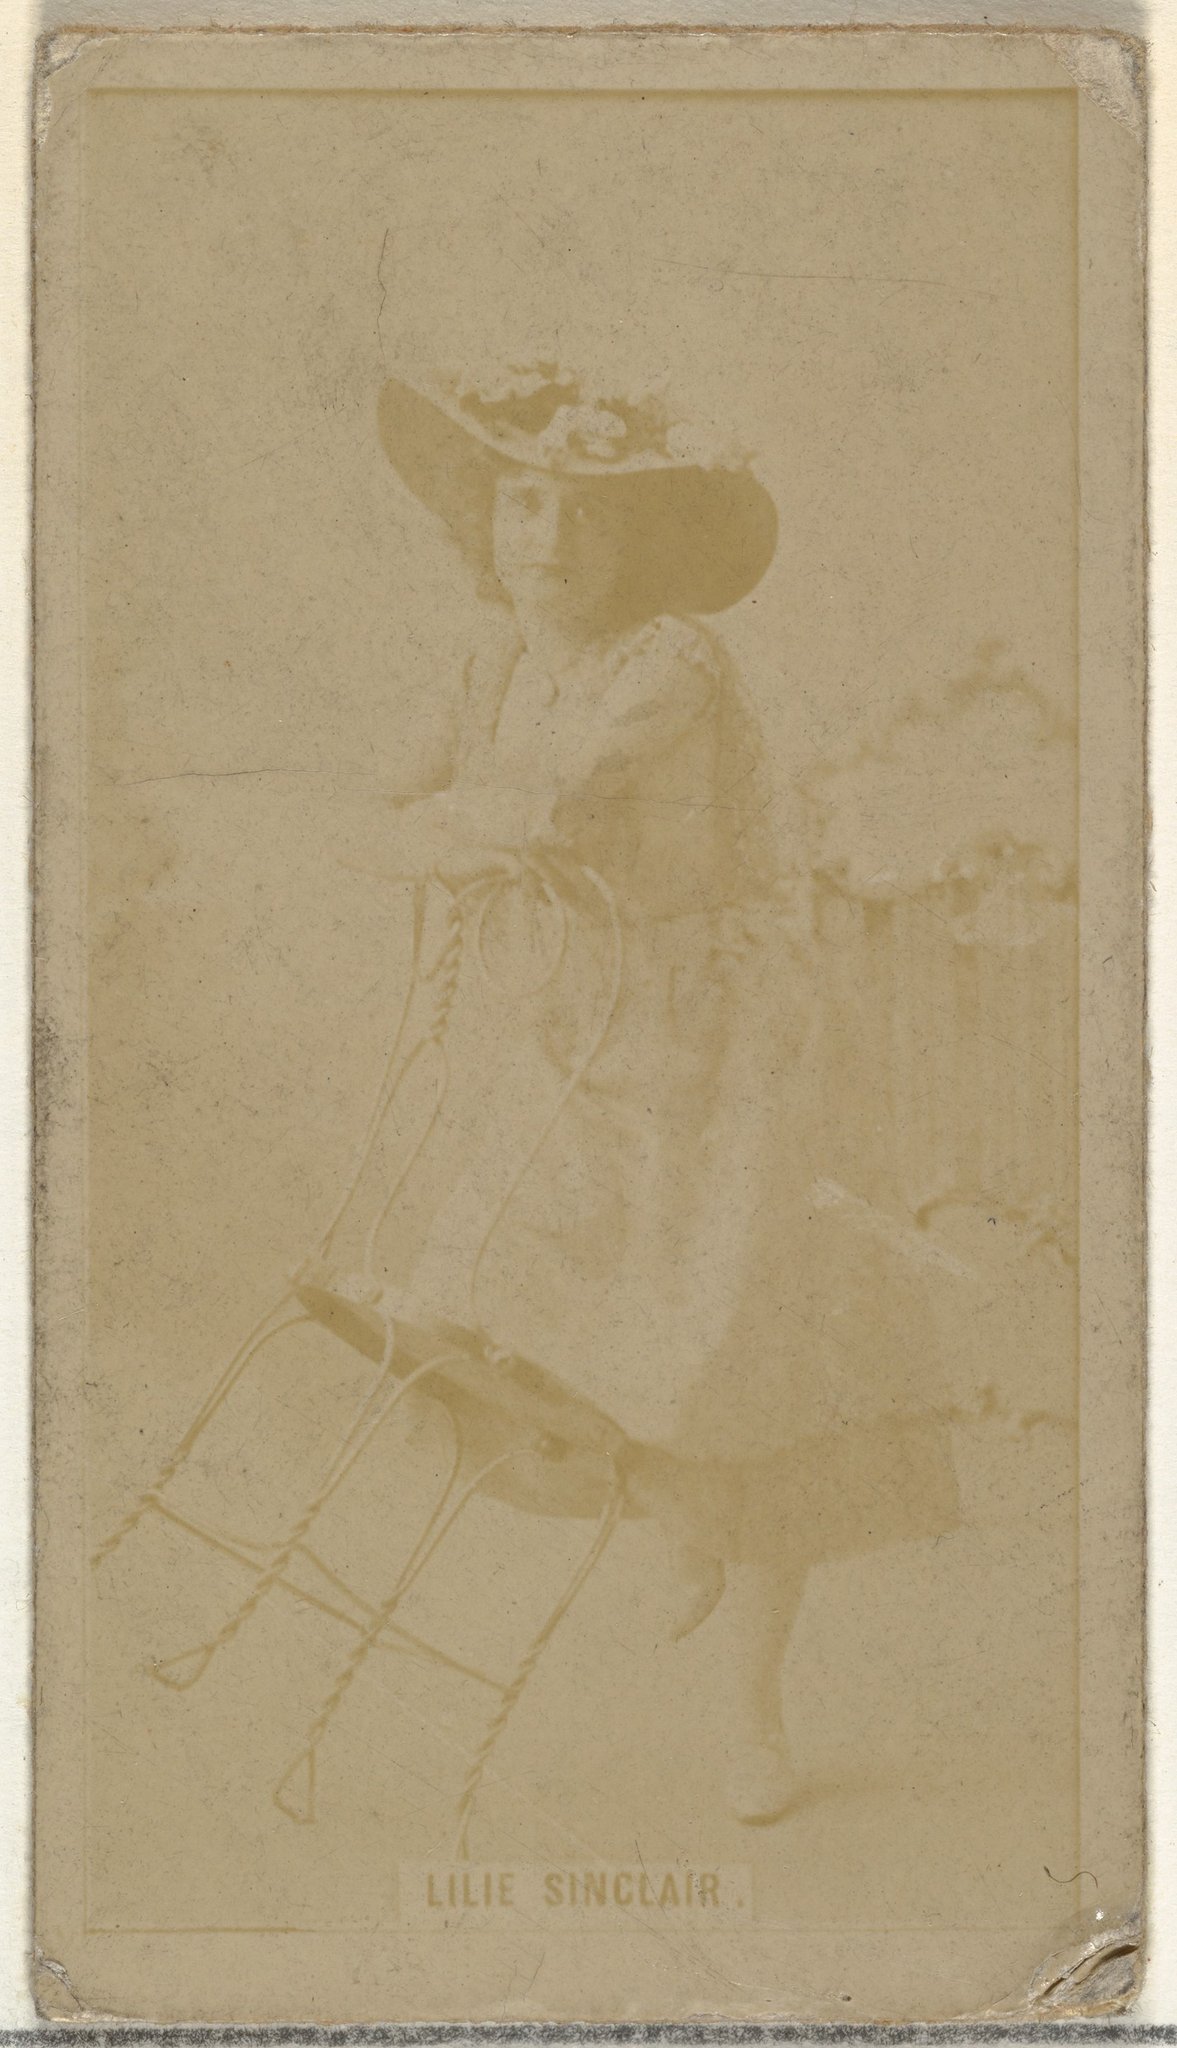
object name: photograph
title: Lilie Sinclair, from the Actors and Actresses series (N145-8) issued by Duke Sons & Co. to promote Duke Cigarettes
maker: w. duke, sons & co.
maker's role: publisher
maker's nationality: american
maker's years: 1870-1920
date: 1891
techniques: albumen silver print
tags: portraits,women,actresses